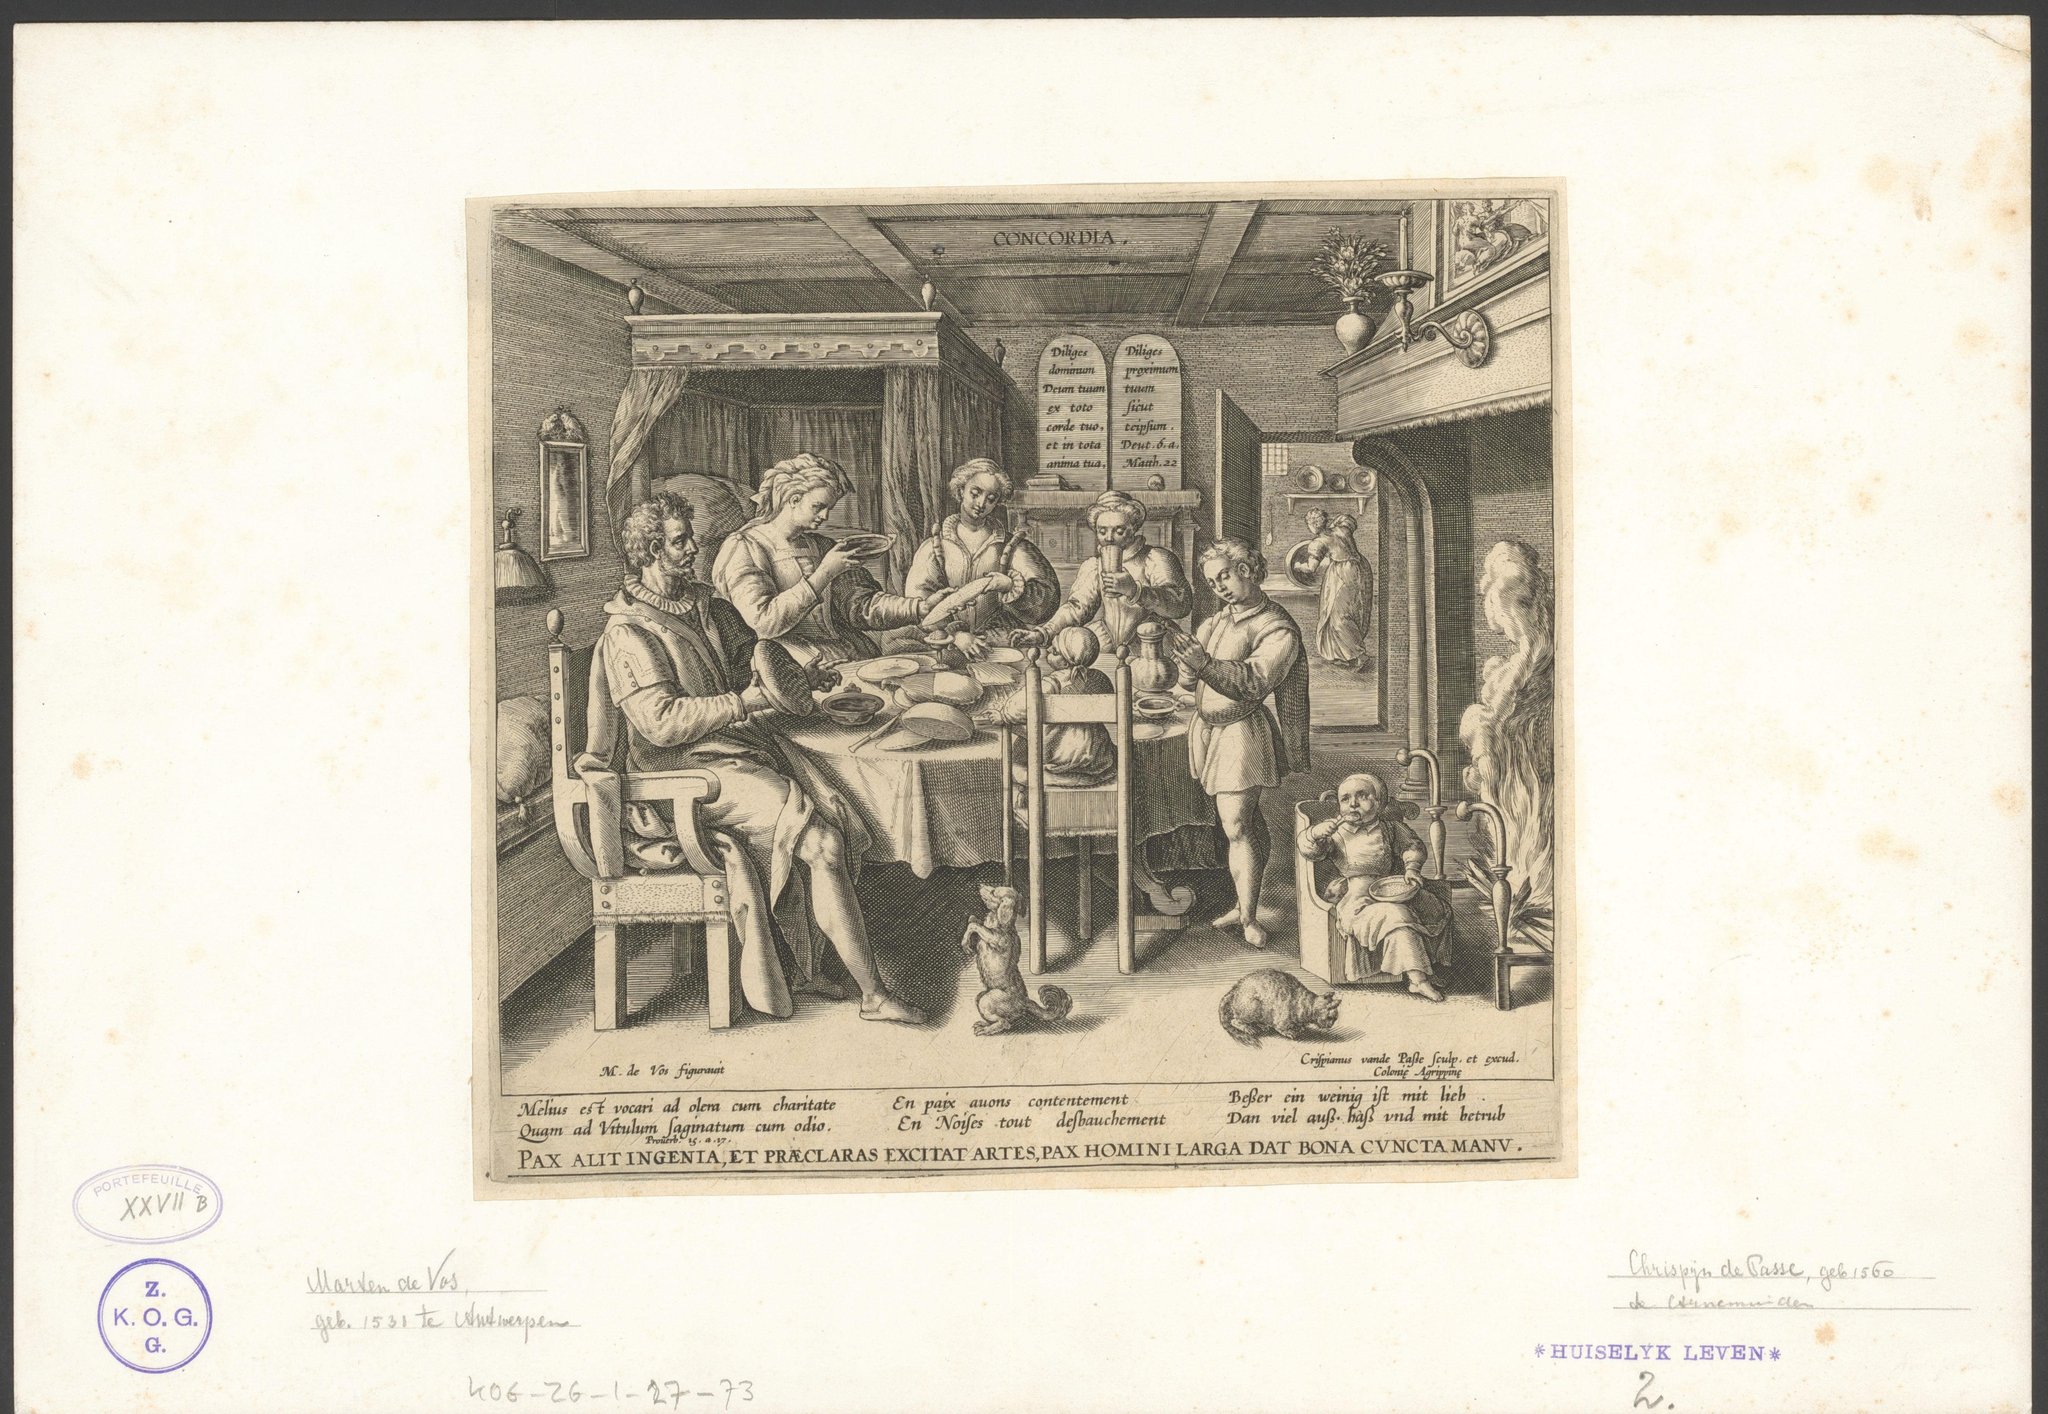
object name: print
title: Concordia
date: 1589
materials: paper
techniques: engraving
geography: cologne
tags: concord, 'concordia' ~ one of the seven gifts of the soul, bed with tester, baby-chair, prayer at table, saying grace, dining-room, (family) meal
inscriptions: collector's mark: Lugt 1641, collector's mark